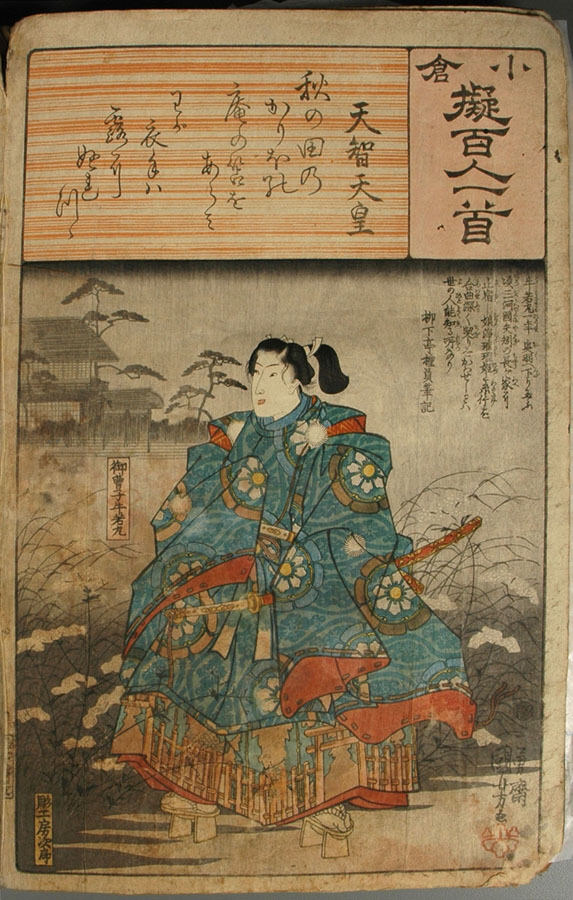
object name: print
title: Album of Ninety-eight Prints from the series Ogura Imitations of One Hundred Poems by One Hundred Poets (Ogura nazorae hyakunin isshu)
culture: japanese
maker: utagawa kuniyoshi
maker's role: artist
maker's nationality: japanese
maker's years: 1797-1861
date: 1801-1900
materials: ink, paper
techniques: woodblock print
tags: houses,women